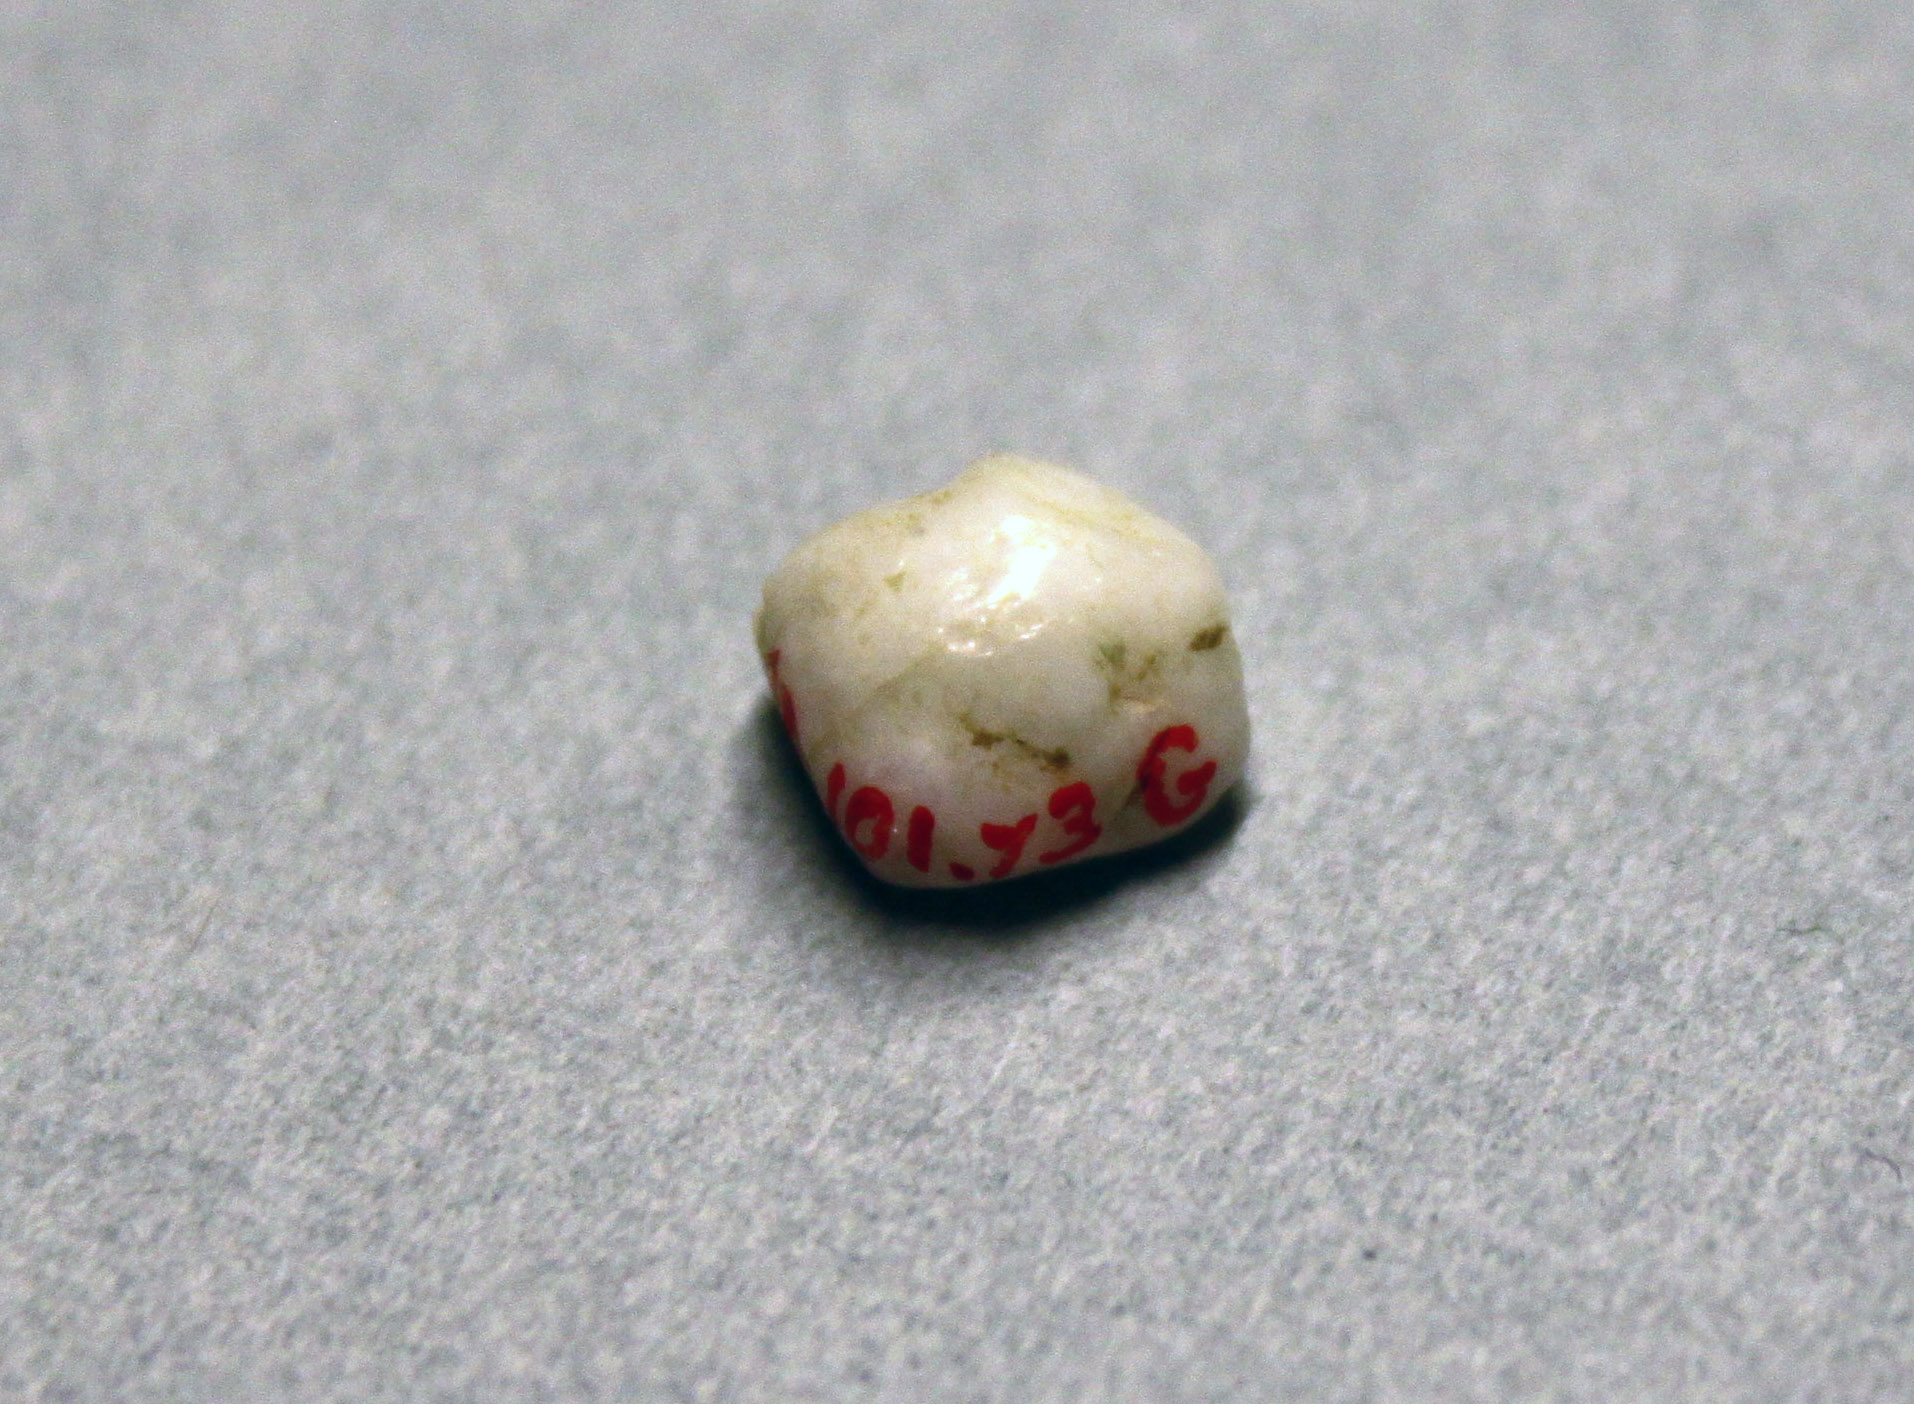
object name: bead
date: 701-1200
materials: stone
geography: iran